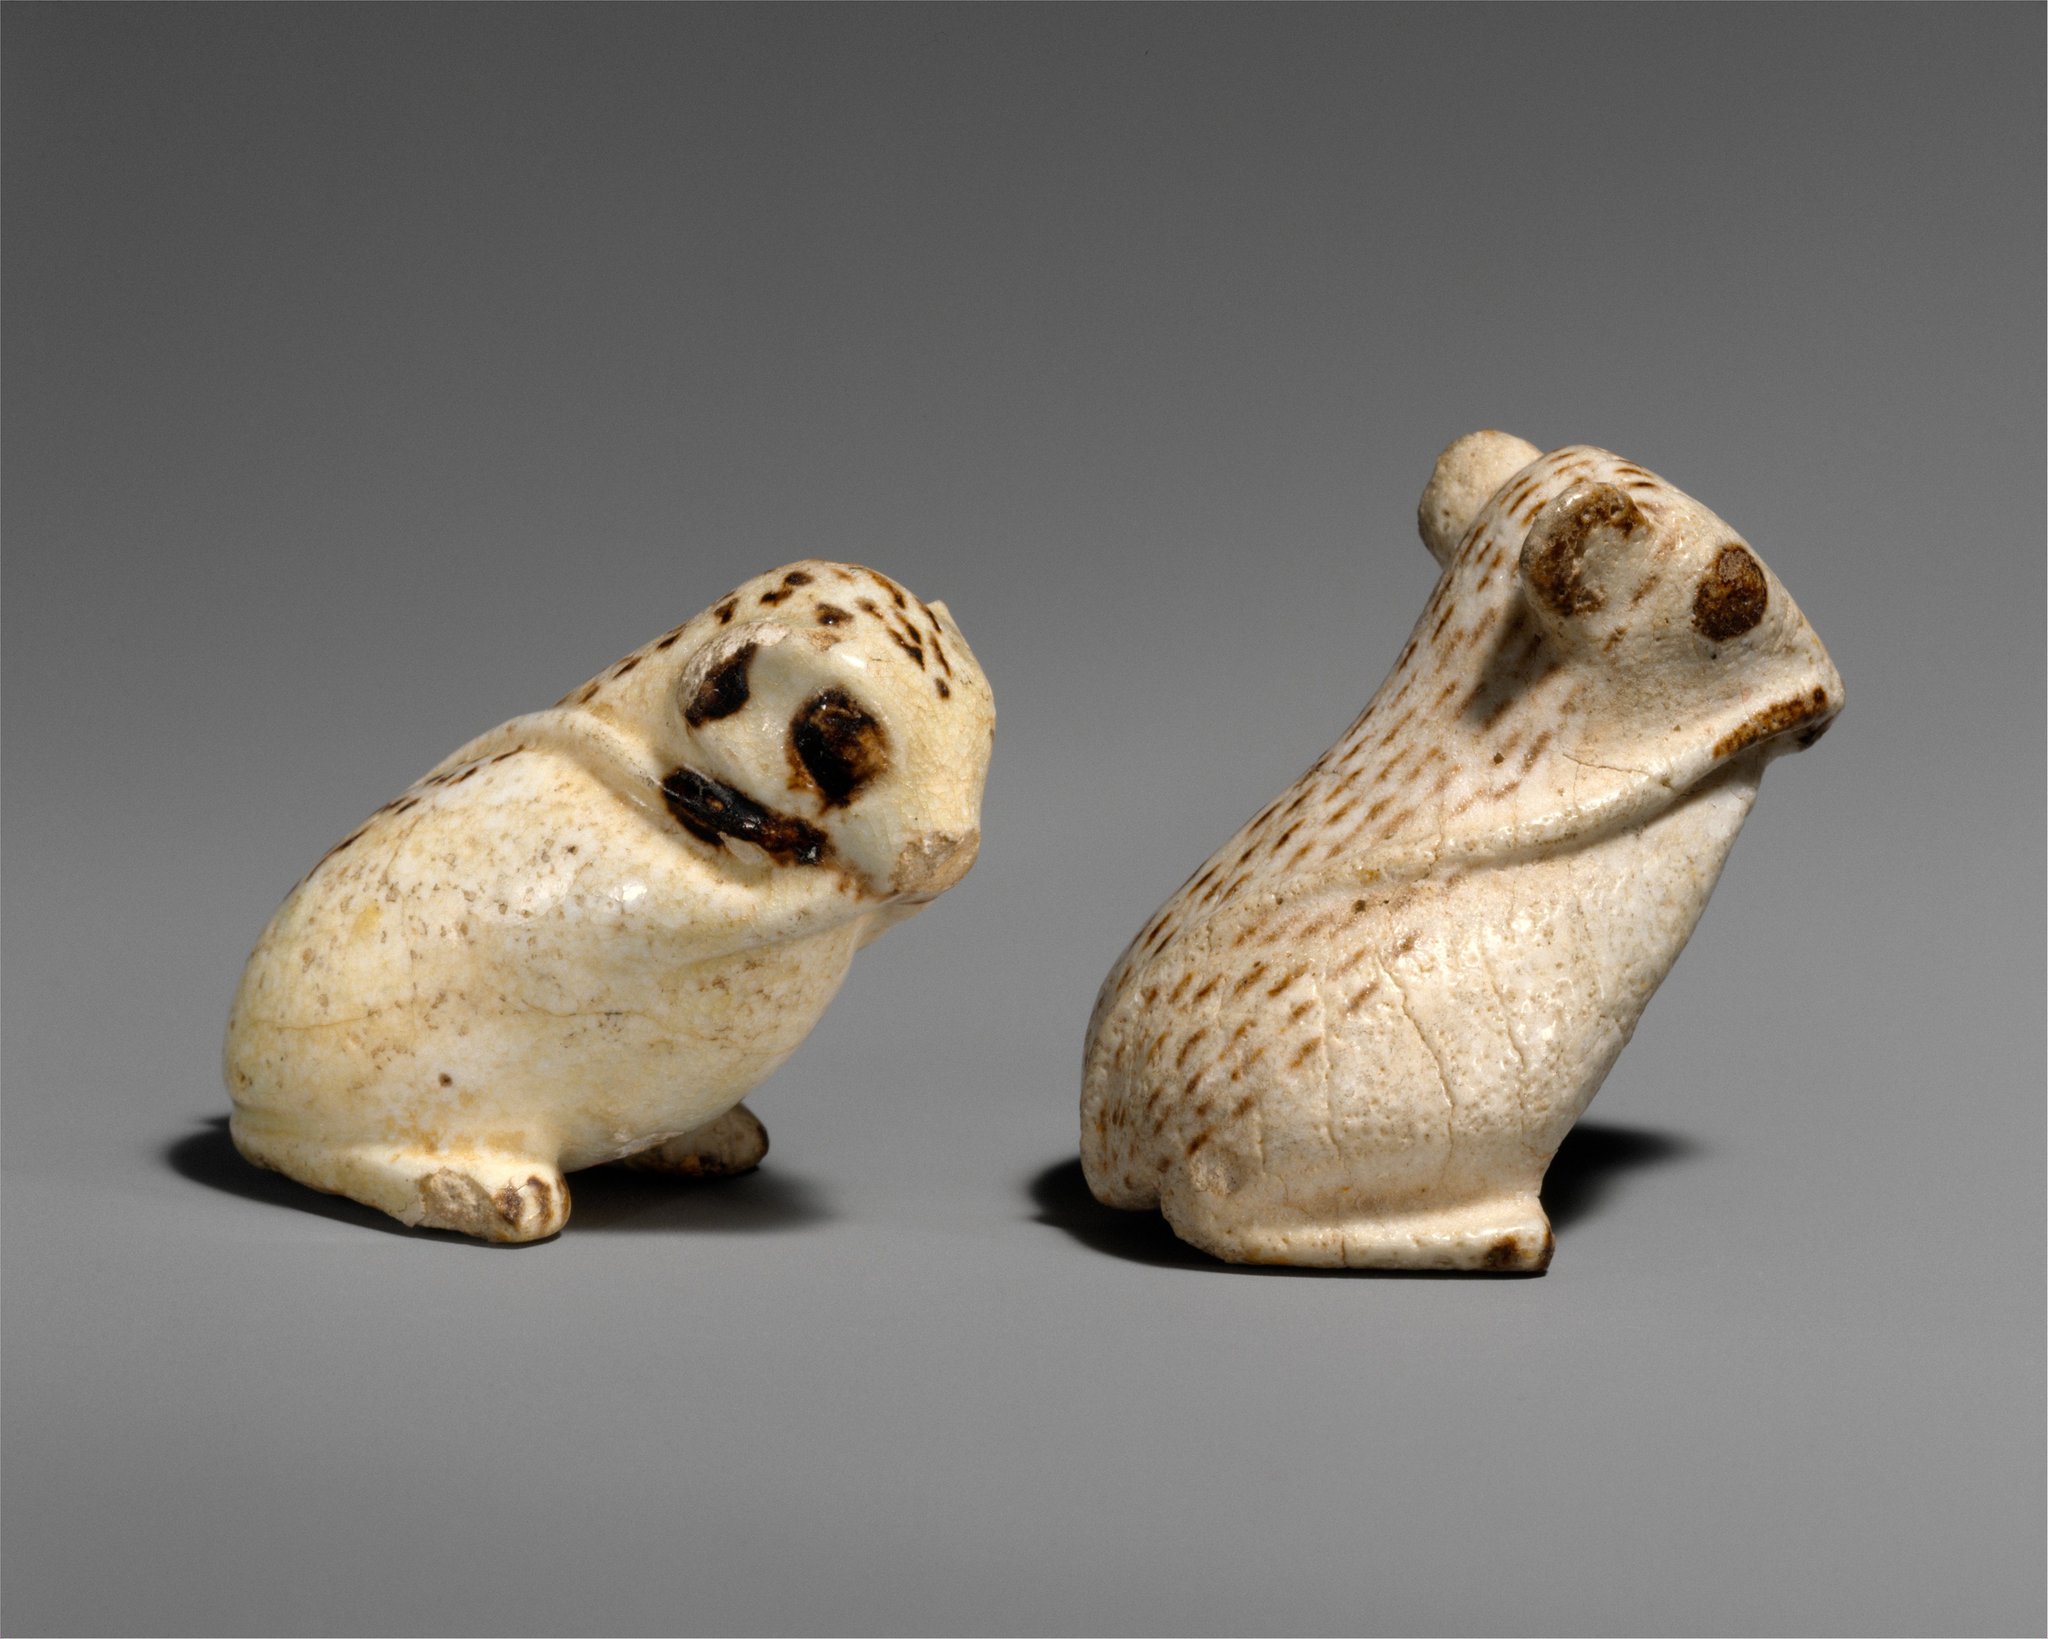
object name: figurine, jerboa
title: Jerboa figurine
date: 1850-1640 BCE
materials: faience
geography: memphite region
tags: animals